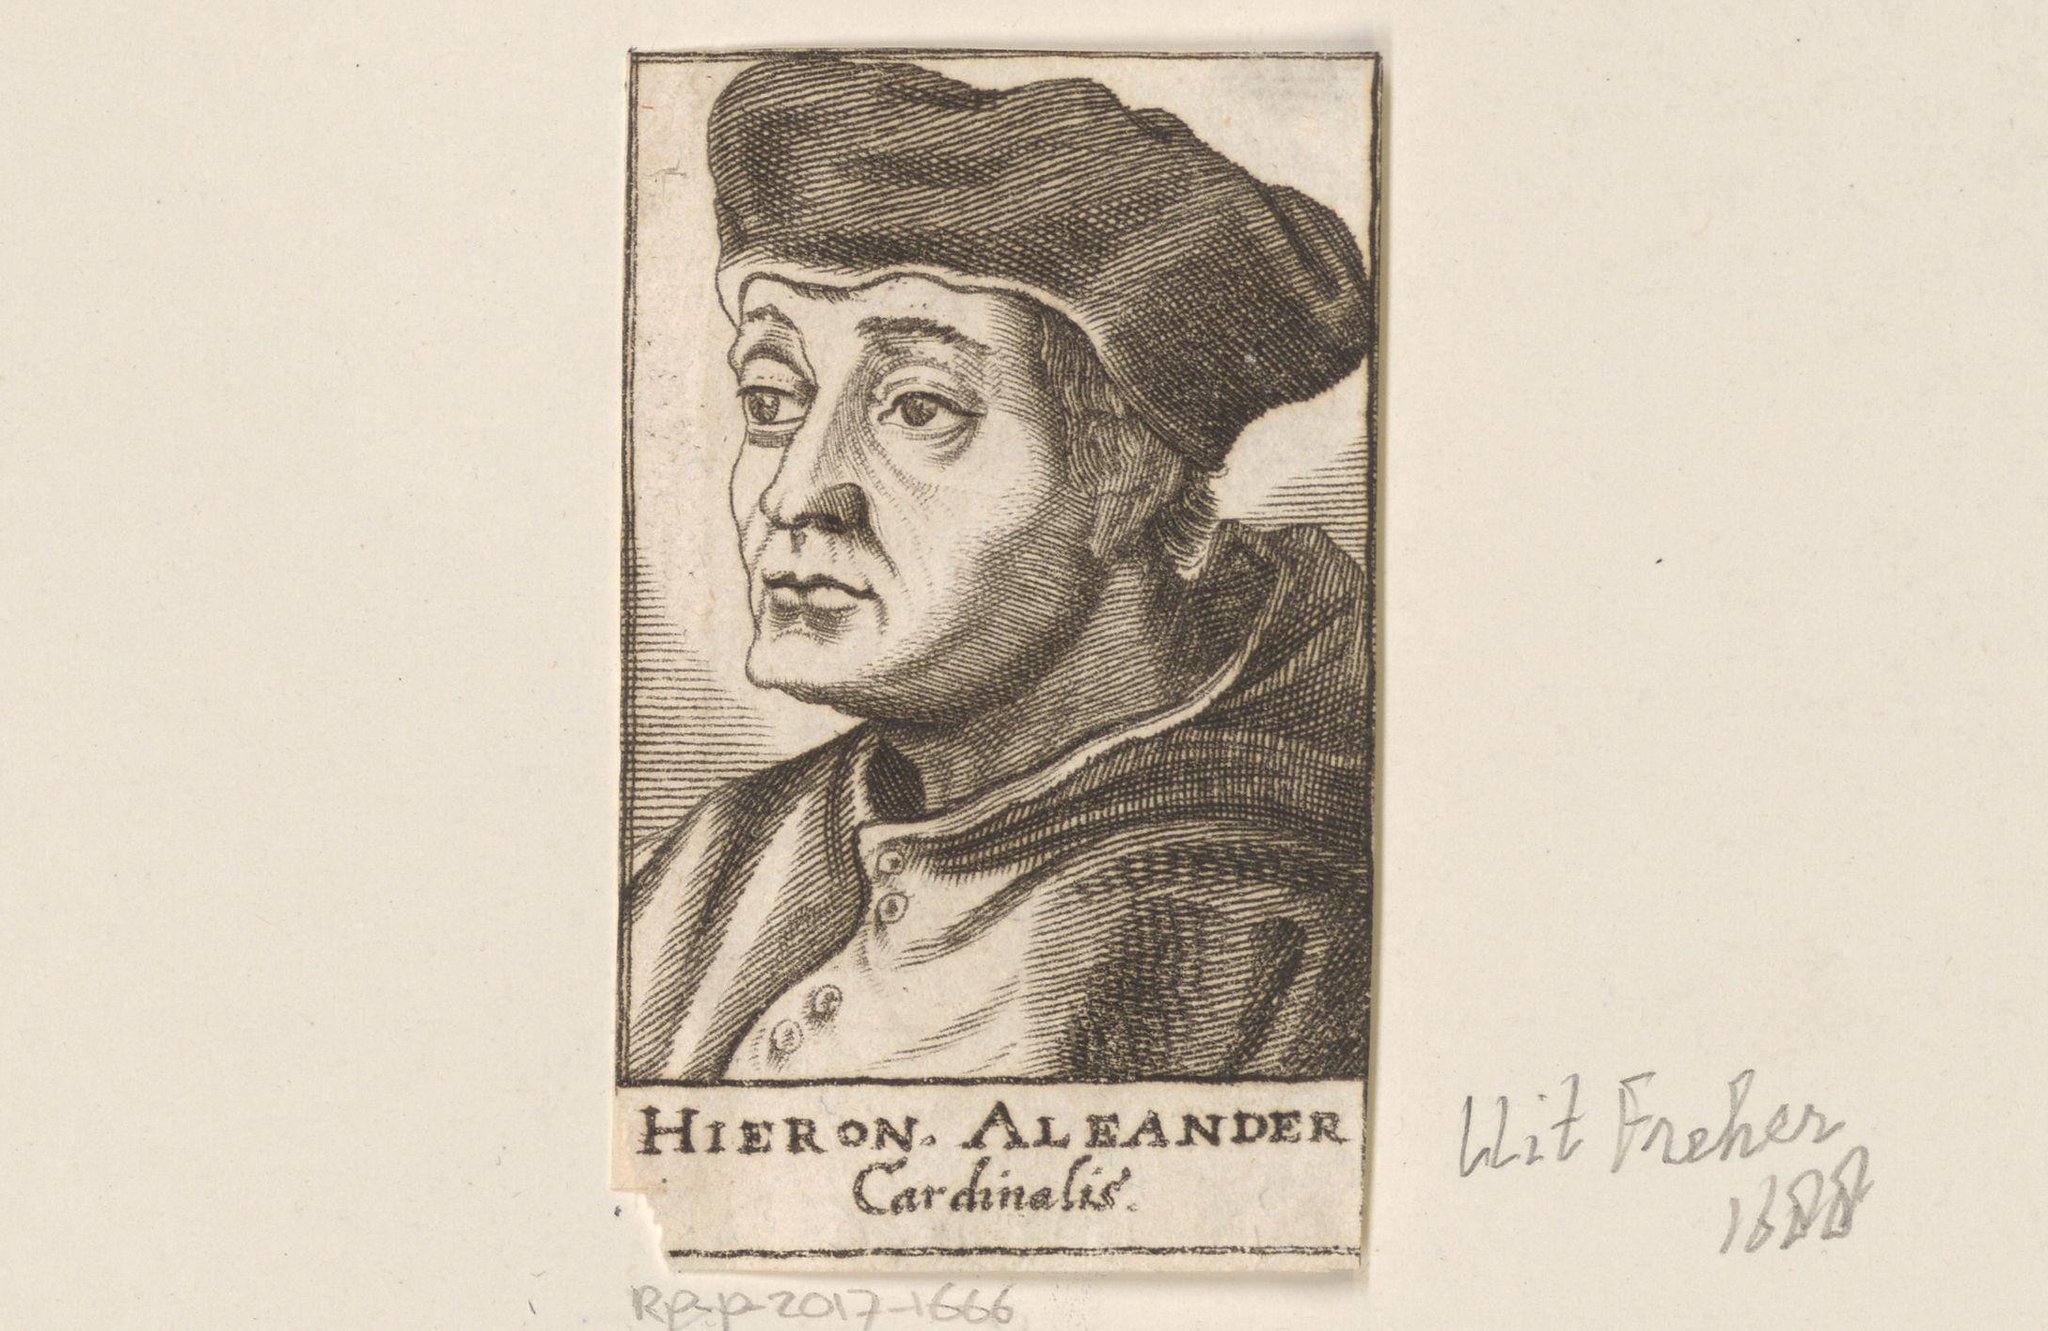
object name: book illustration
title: Portret van Girolamo Aleandro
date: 1688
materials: paper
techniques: engraving, etching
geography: nuremberg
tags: humanist, girolamo aleandro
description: Prent uit: Freher, Paul. Theatrum virorum eruditione clarorum. Neurenberg: Johann Hoffmann, 1688.